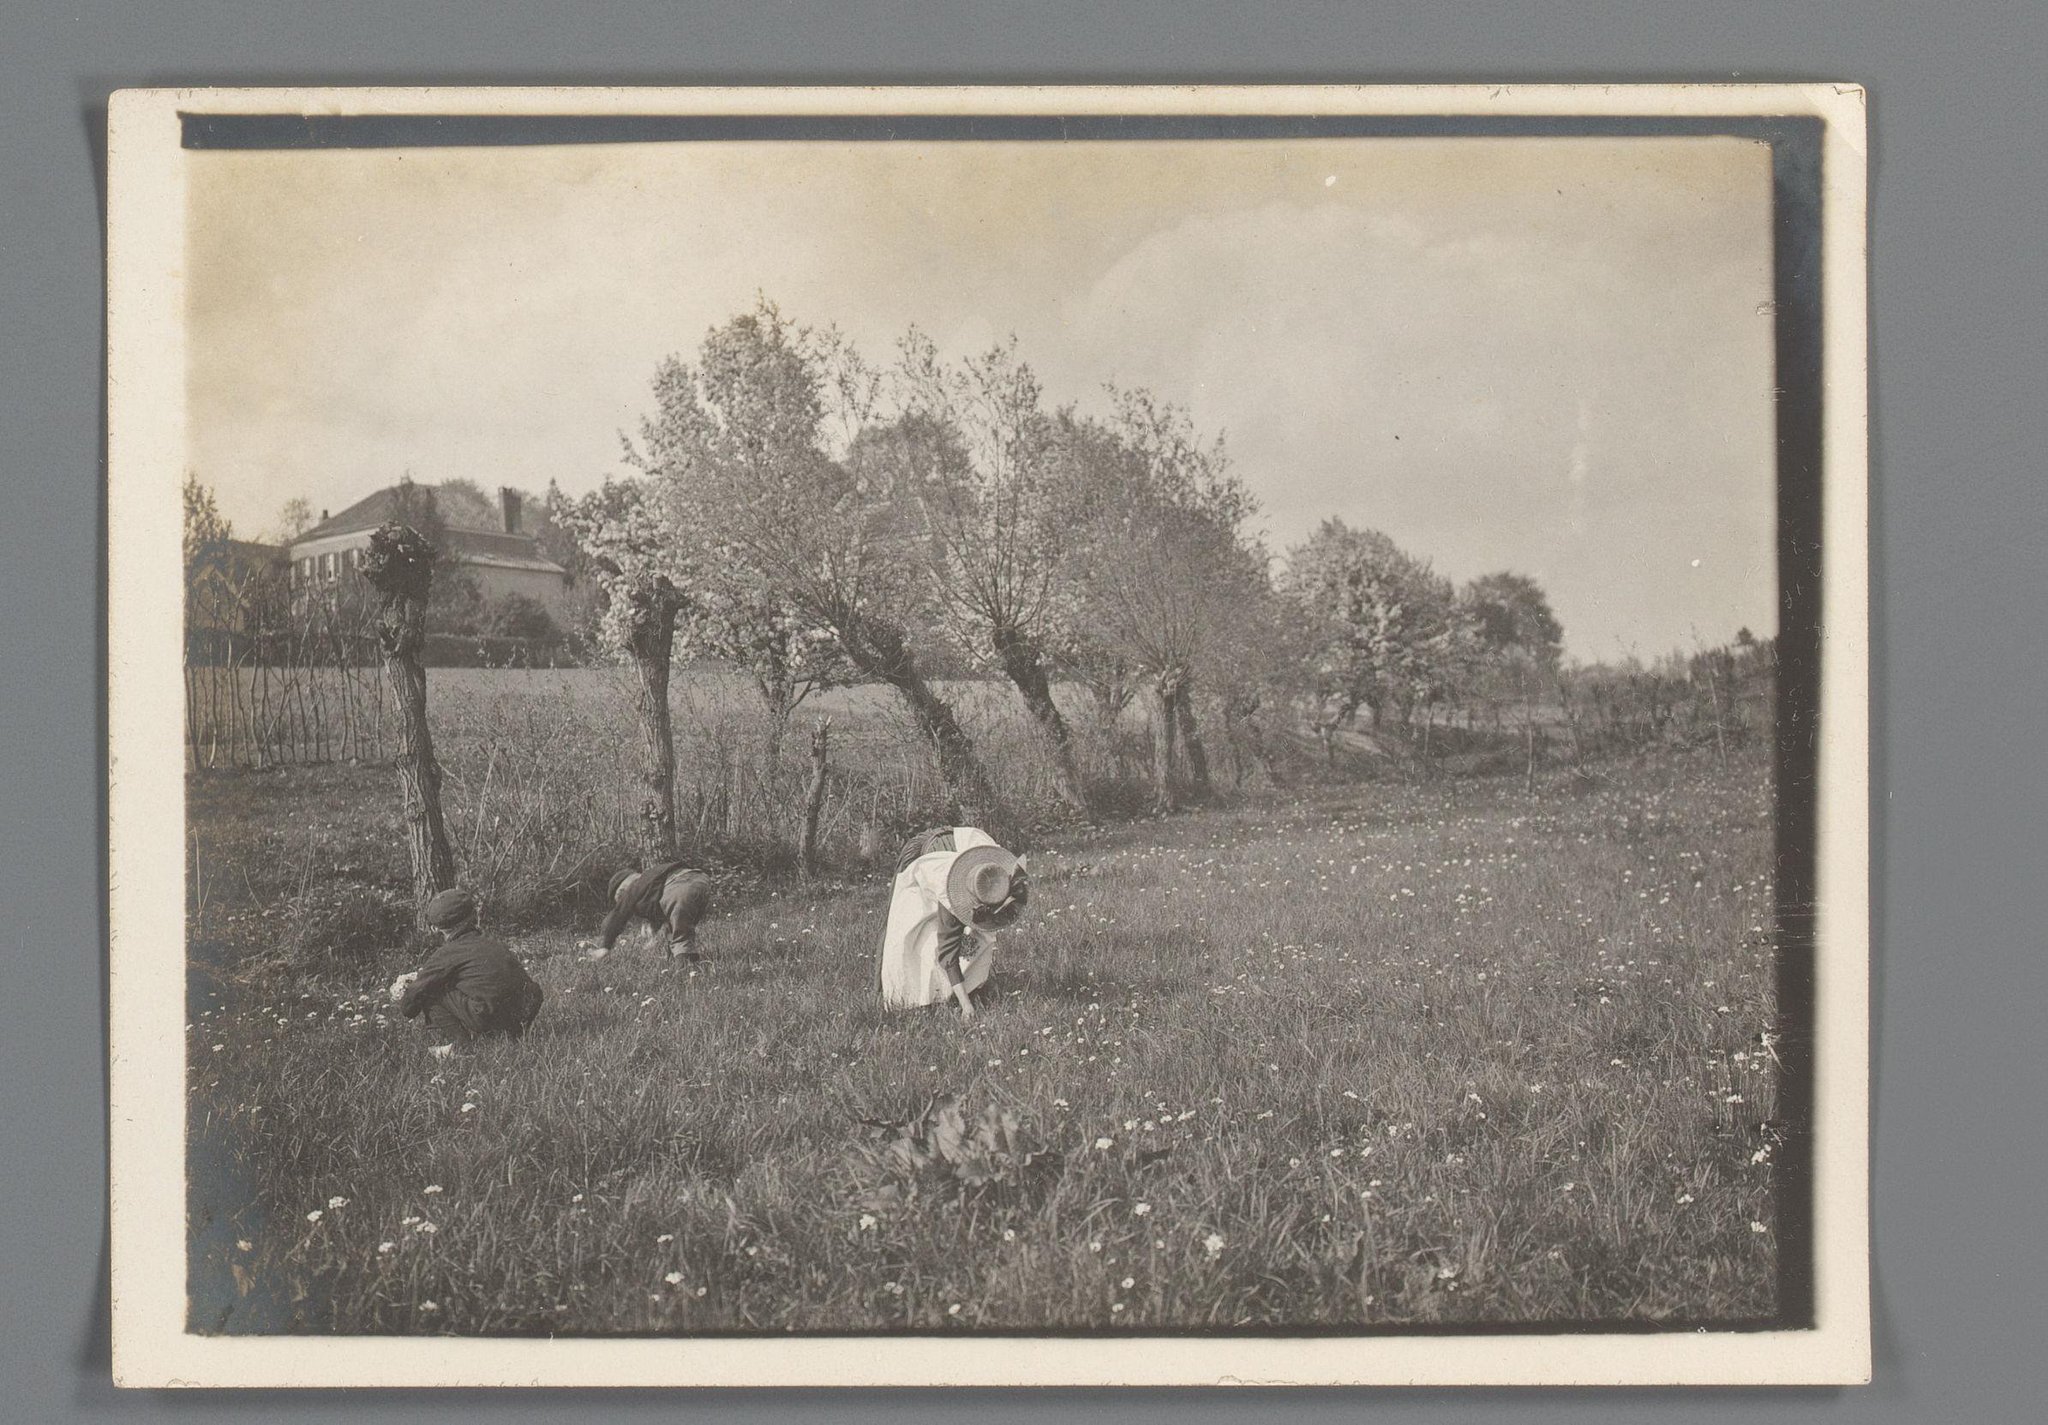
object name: photograph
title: Vrouw en twee kinderen plukken bloemen in een weide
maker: willem de jong (fotograaf)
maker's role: arts, fotograaf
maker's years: 1864-1918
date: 1895-1918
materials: paper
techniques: gelatin silver print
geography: netherlands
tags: picking flowers, child, meadow, pasture